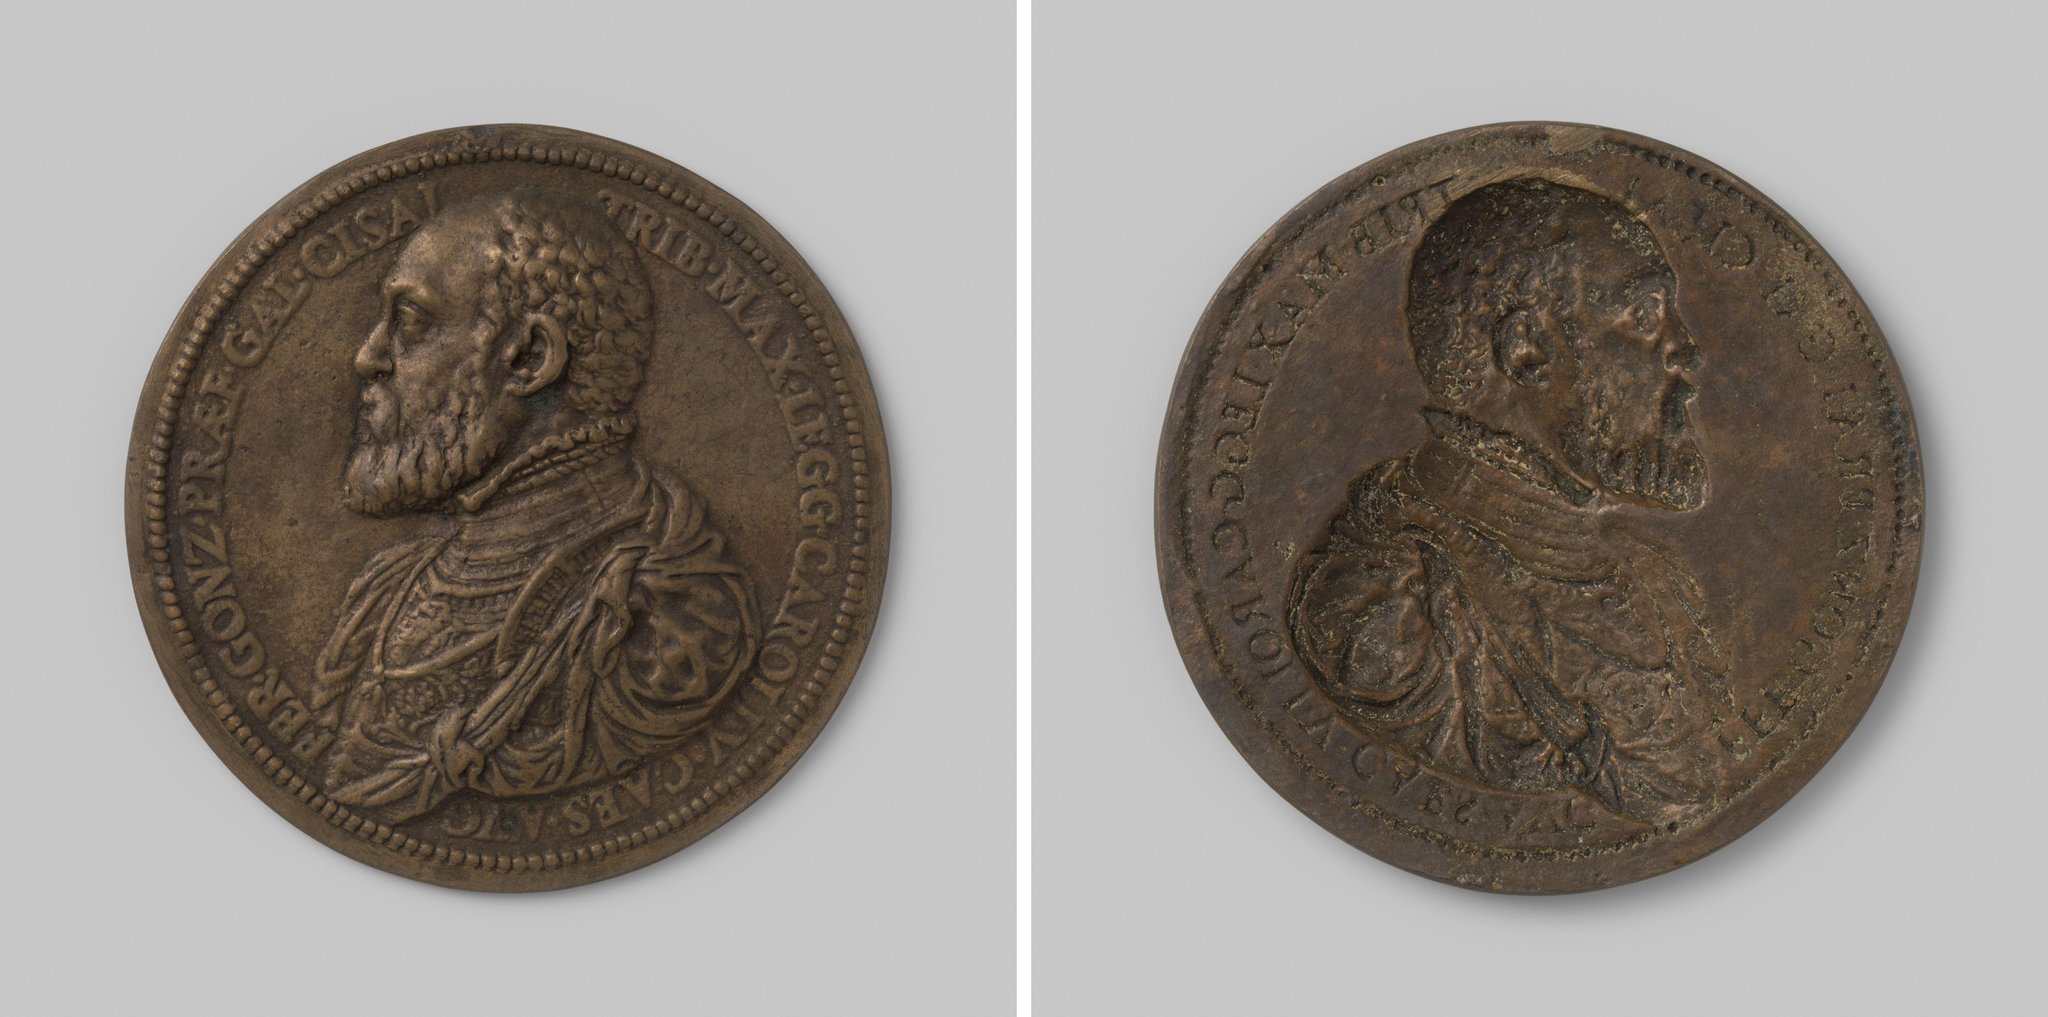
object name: copy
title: Ferrante Gonzaga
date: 1557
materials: bronze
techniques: casting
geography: milan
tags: brussels, italy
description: Bronzen penning. Voorzijde: borststuk man binnen omschrift. Keerzijde: blanco.